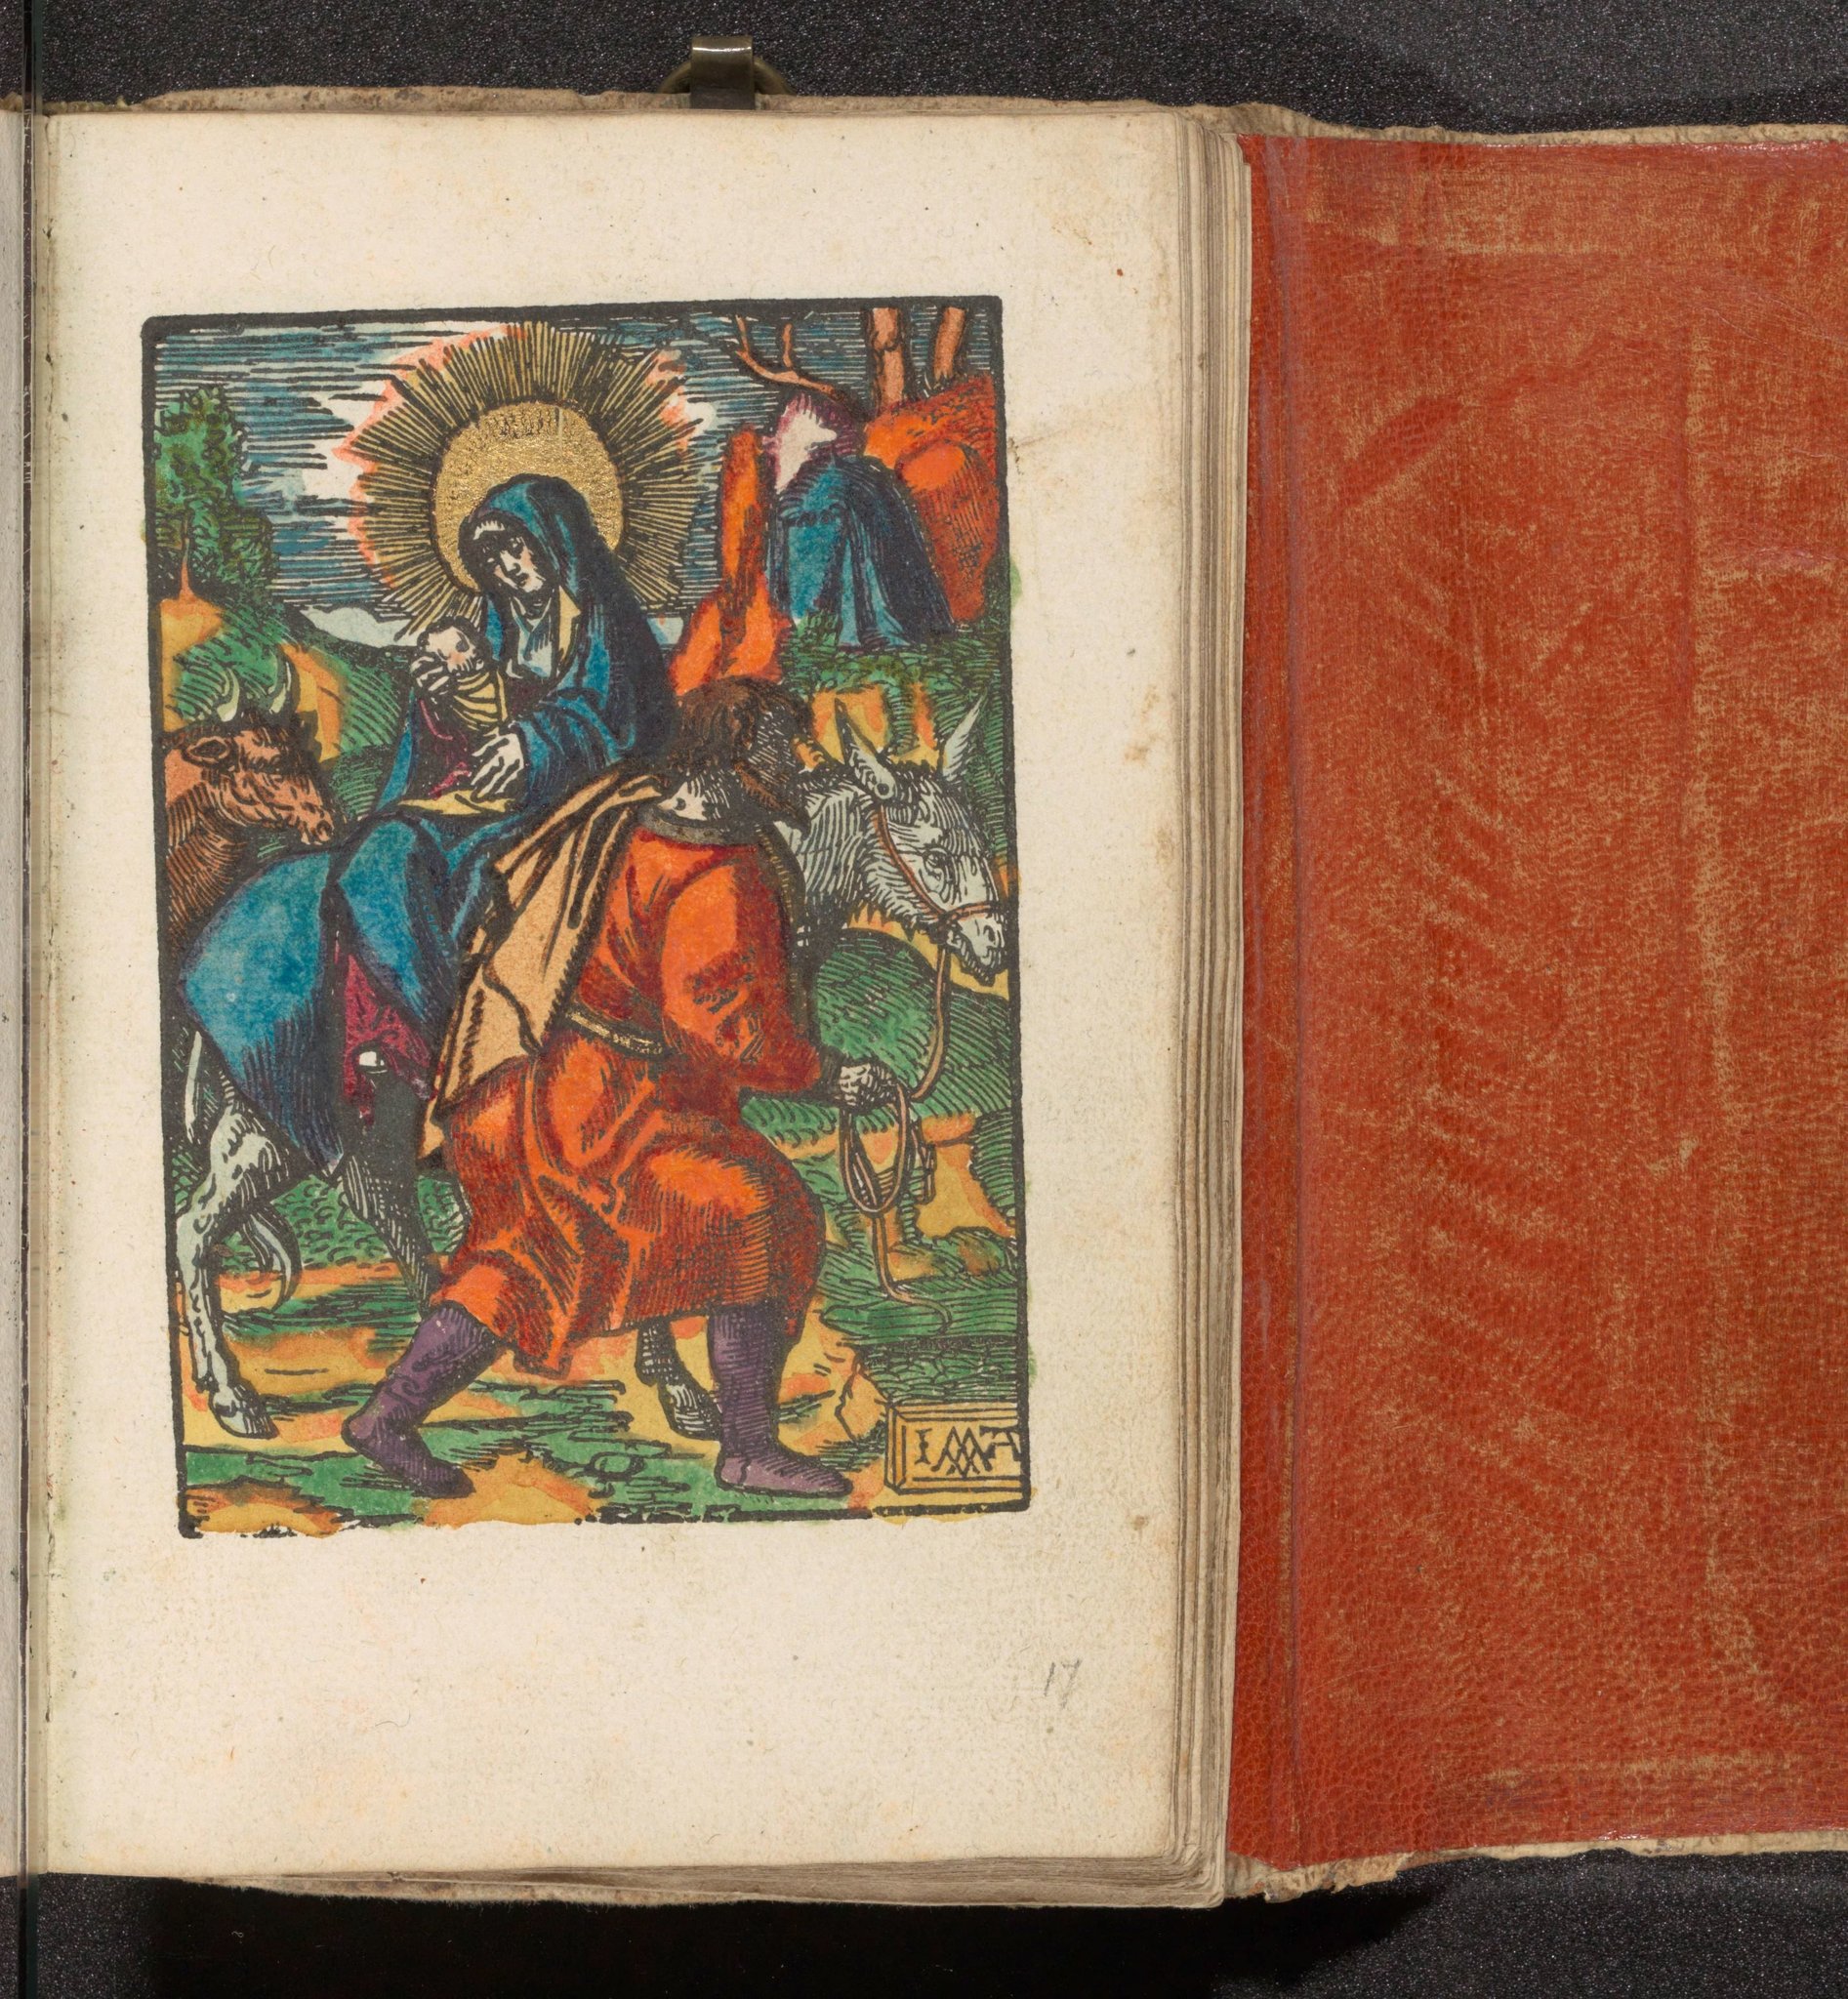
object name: print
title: Stomme Passie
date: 1520-1521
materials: paper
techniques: hand coloring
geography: amsterdam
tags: the flight into egypt: mary, joseph, the child (and sometimes others) on their way; mary usually riding on an ass, book in which illustrations are essential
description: Maria zit met het Christuskind in haar armen op de ezel, die door Jozef wordt voortgeleid. Prent maakt deel uit van een boek.